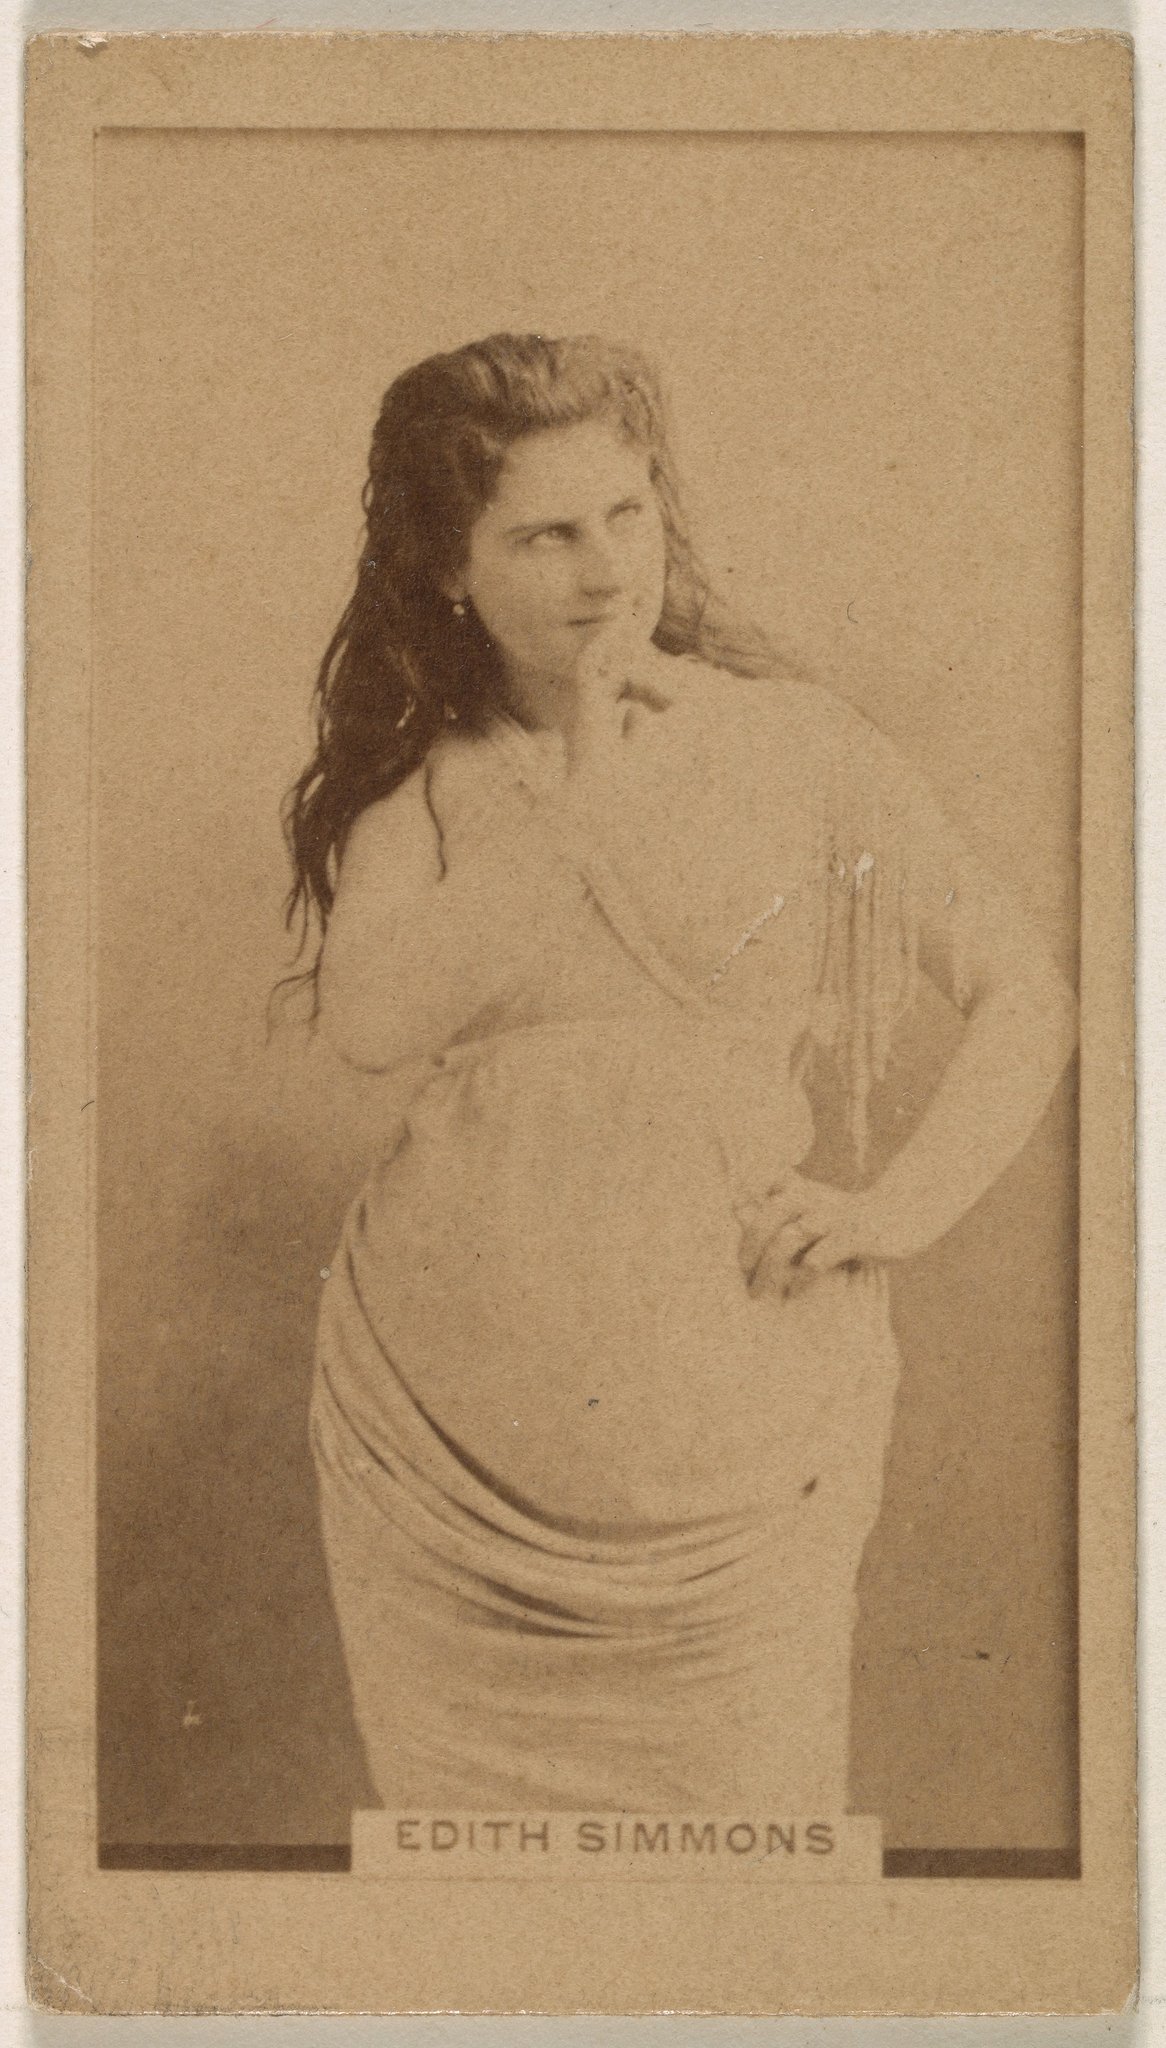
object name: photograph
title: Edith Simmons, from the Actresses series (N245) issued by Kinney Brothers to promote Sweet Caporal Cigarettes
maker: kinney brothers tobacco company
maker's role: publisher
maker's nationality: american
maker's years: 1869-2011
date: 1890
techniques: albumen silver print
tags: portraits,women,actresses